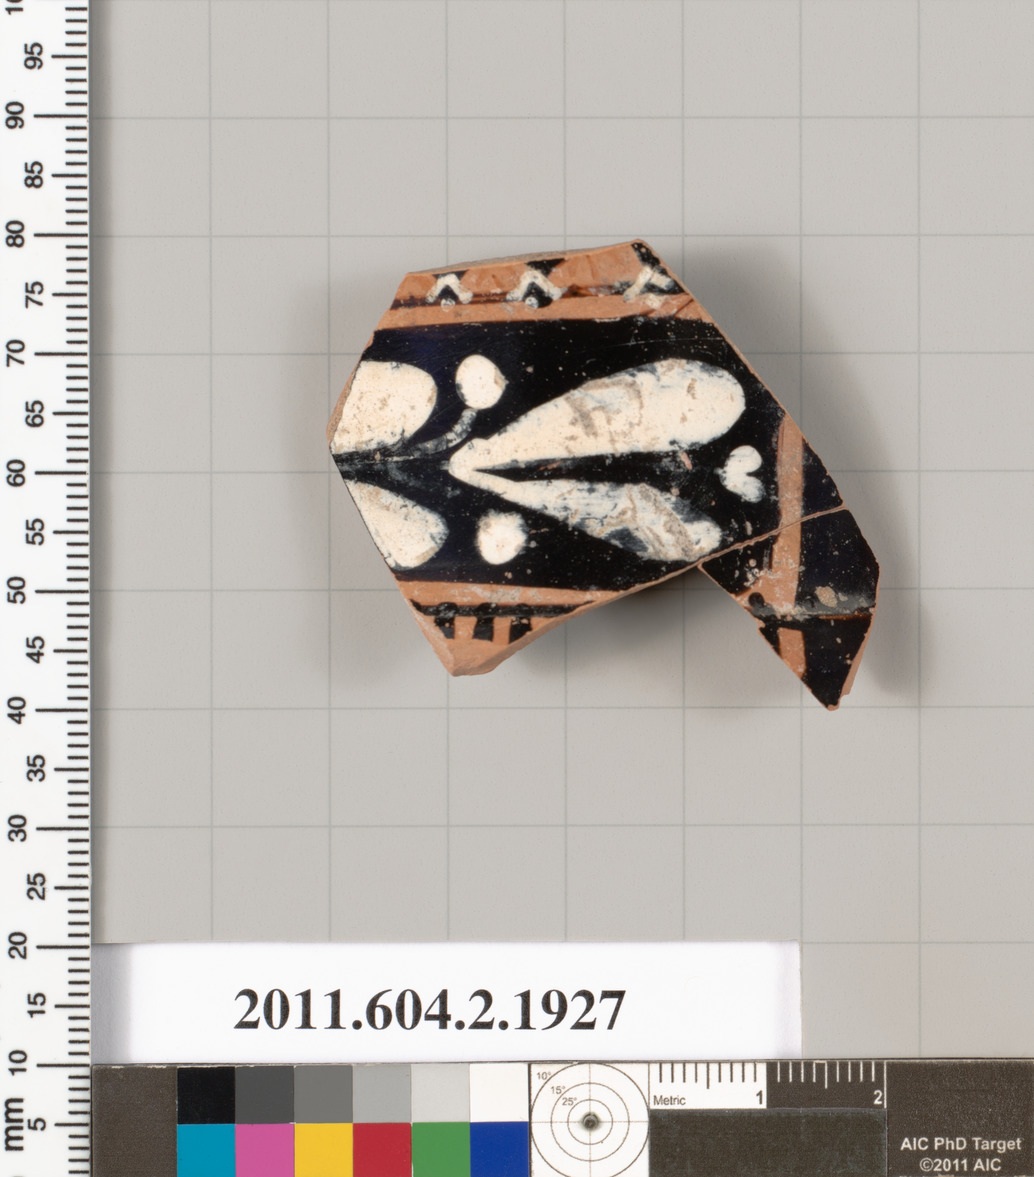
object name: skyphos fragment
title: Terracotta fragment of a skyphos (deep drinking cup)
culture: greek, attic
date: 475-425 BCE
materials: terracotta